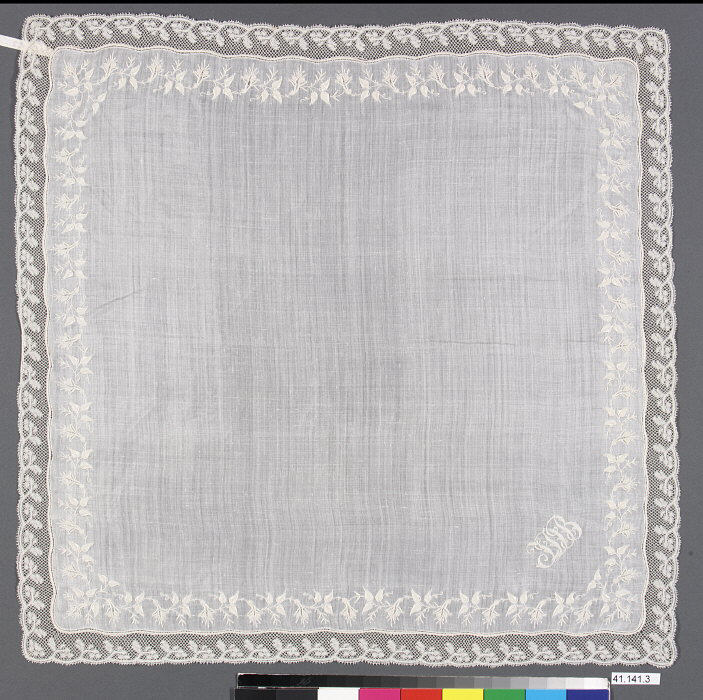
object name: handkerchief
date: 1867-1900